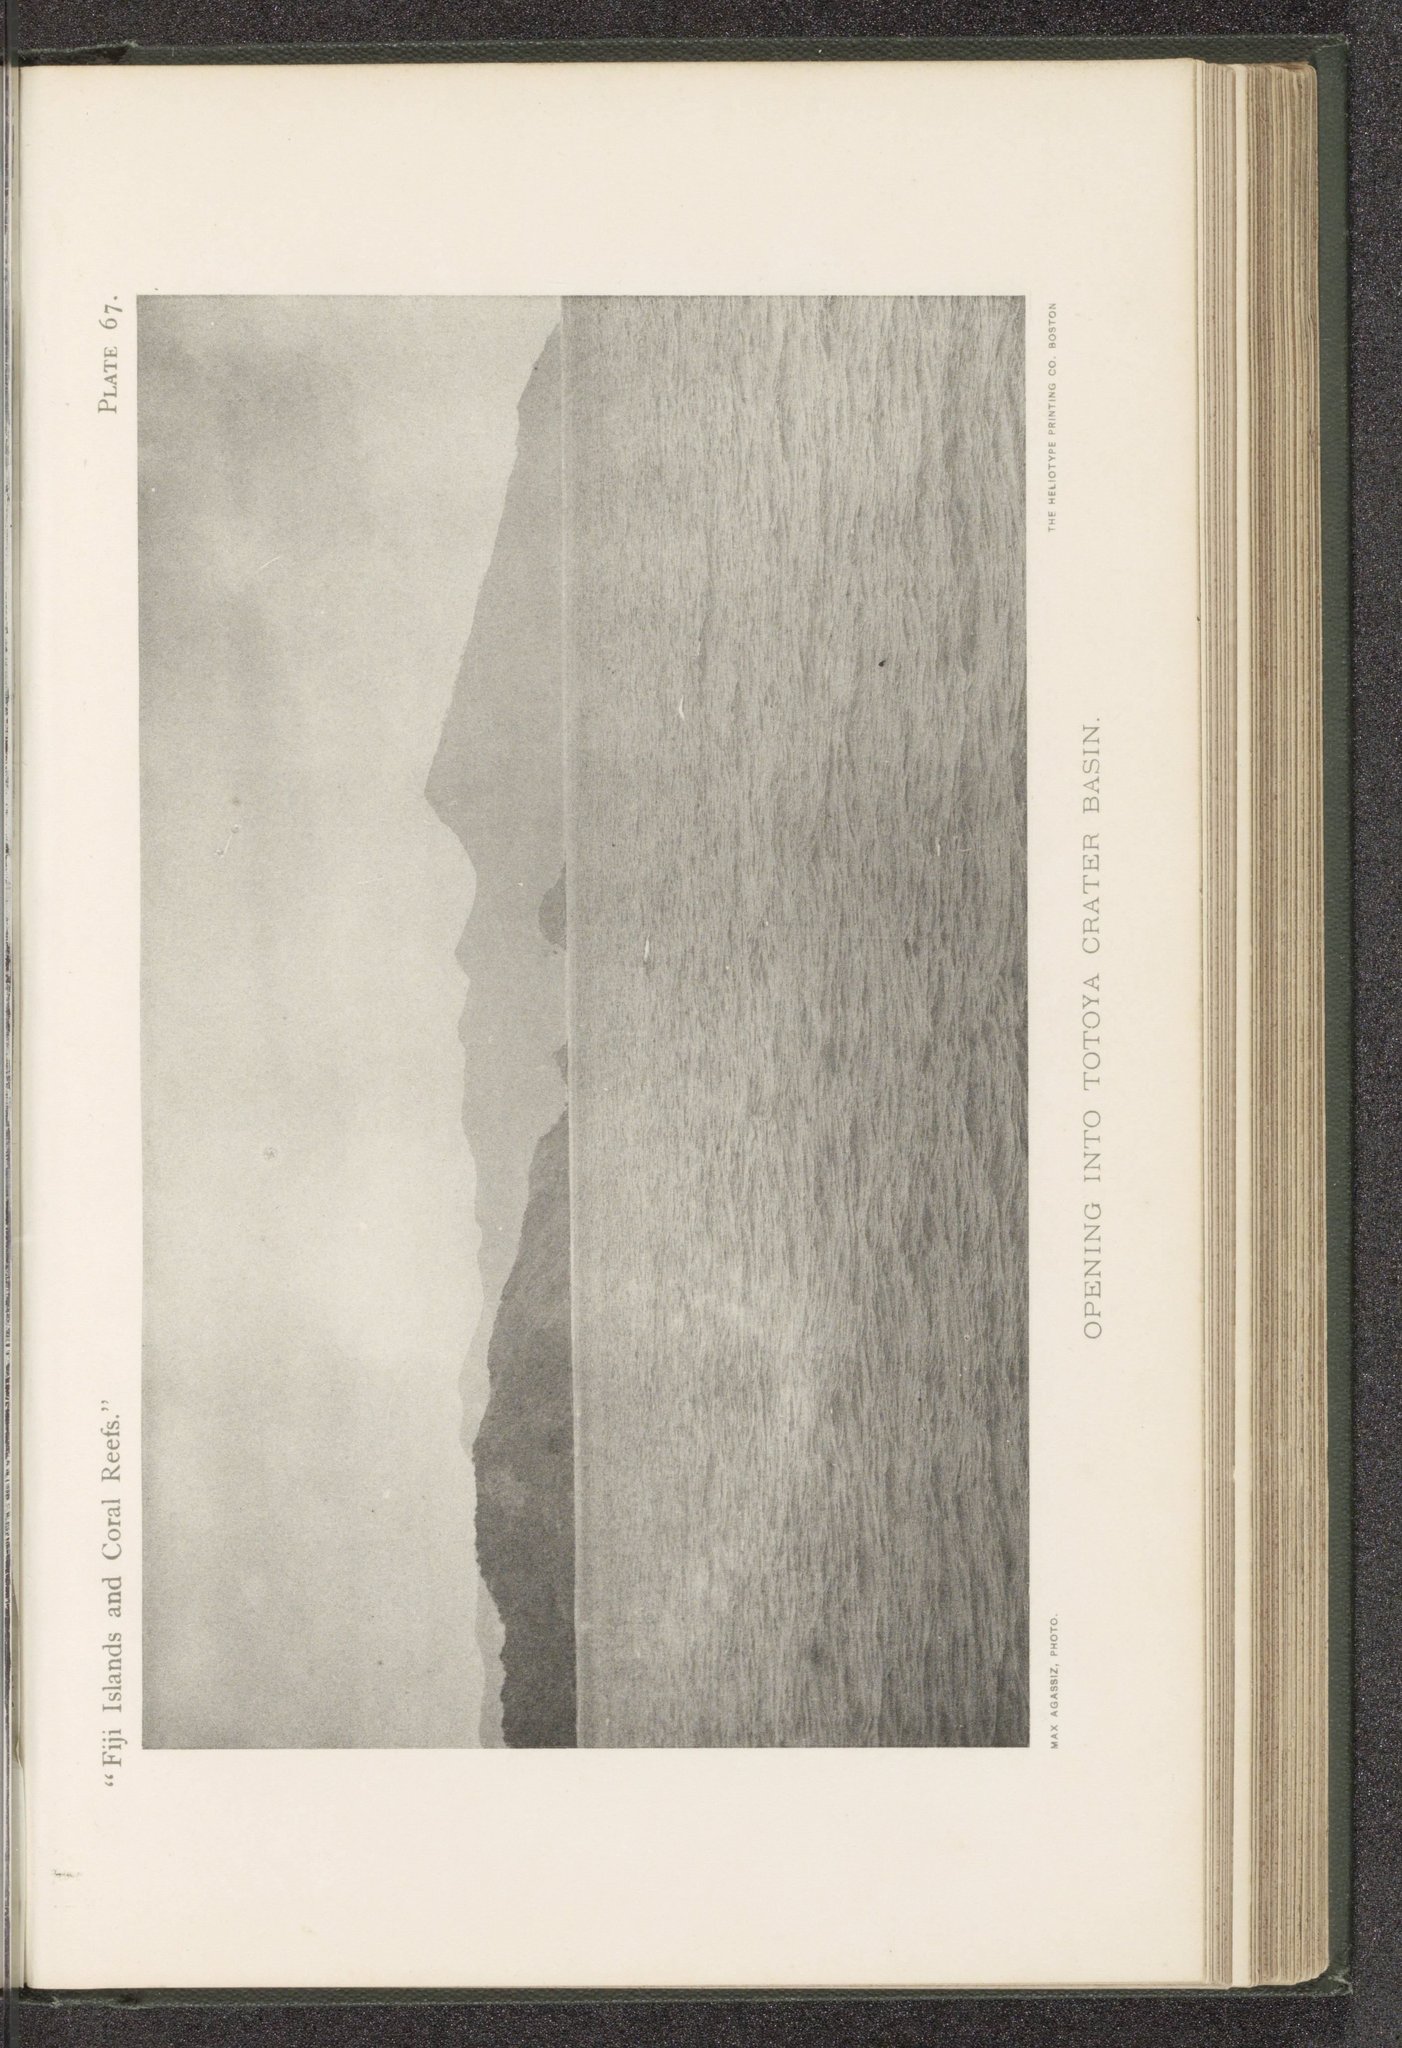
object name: page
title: Gezicht op een kraterbekken in de zee bij Totoya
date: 1885-1899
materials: paper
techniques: photograph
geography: boston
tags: island, ocean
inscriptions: number: ‘Plate 67.’, name: ‘The Heliotype Printing Co. Boston’, name: ‘Max Agassiz, Photo’